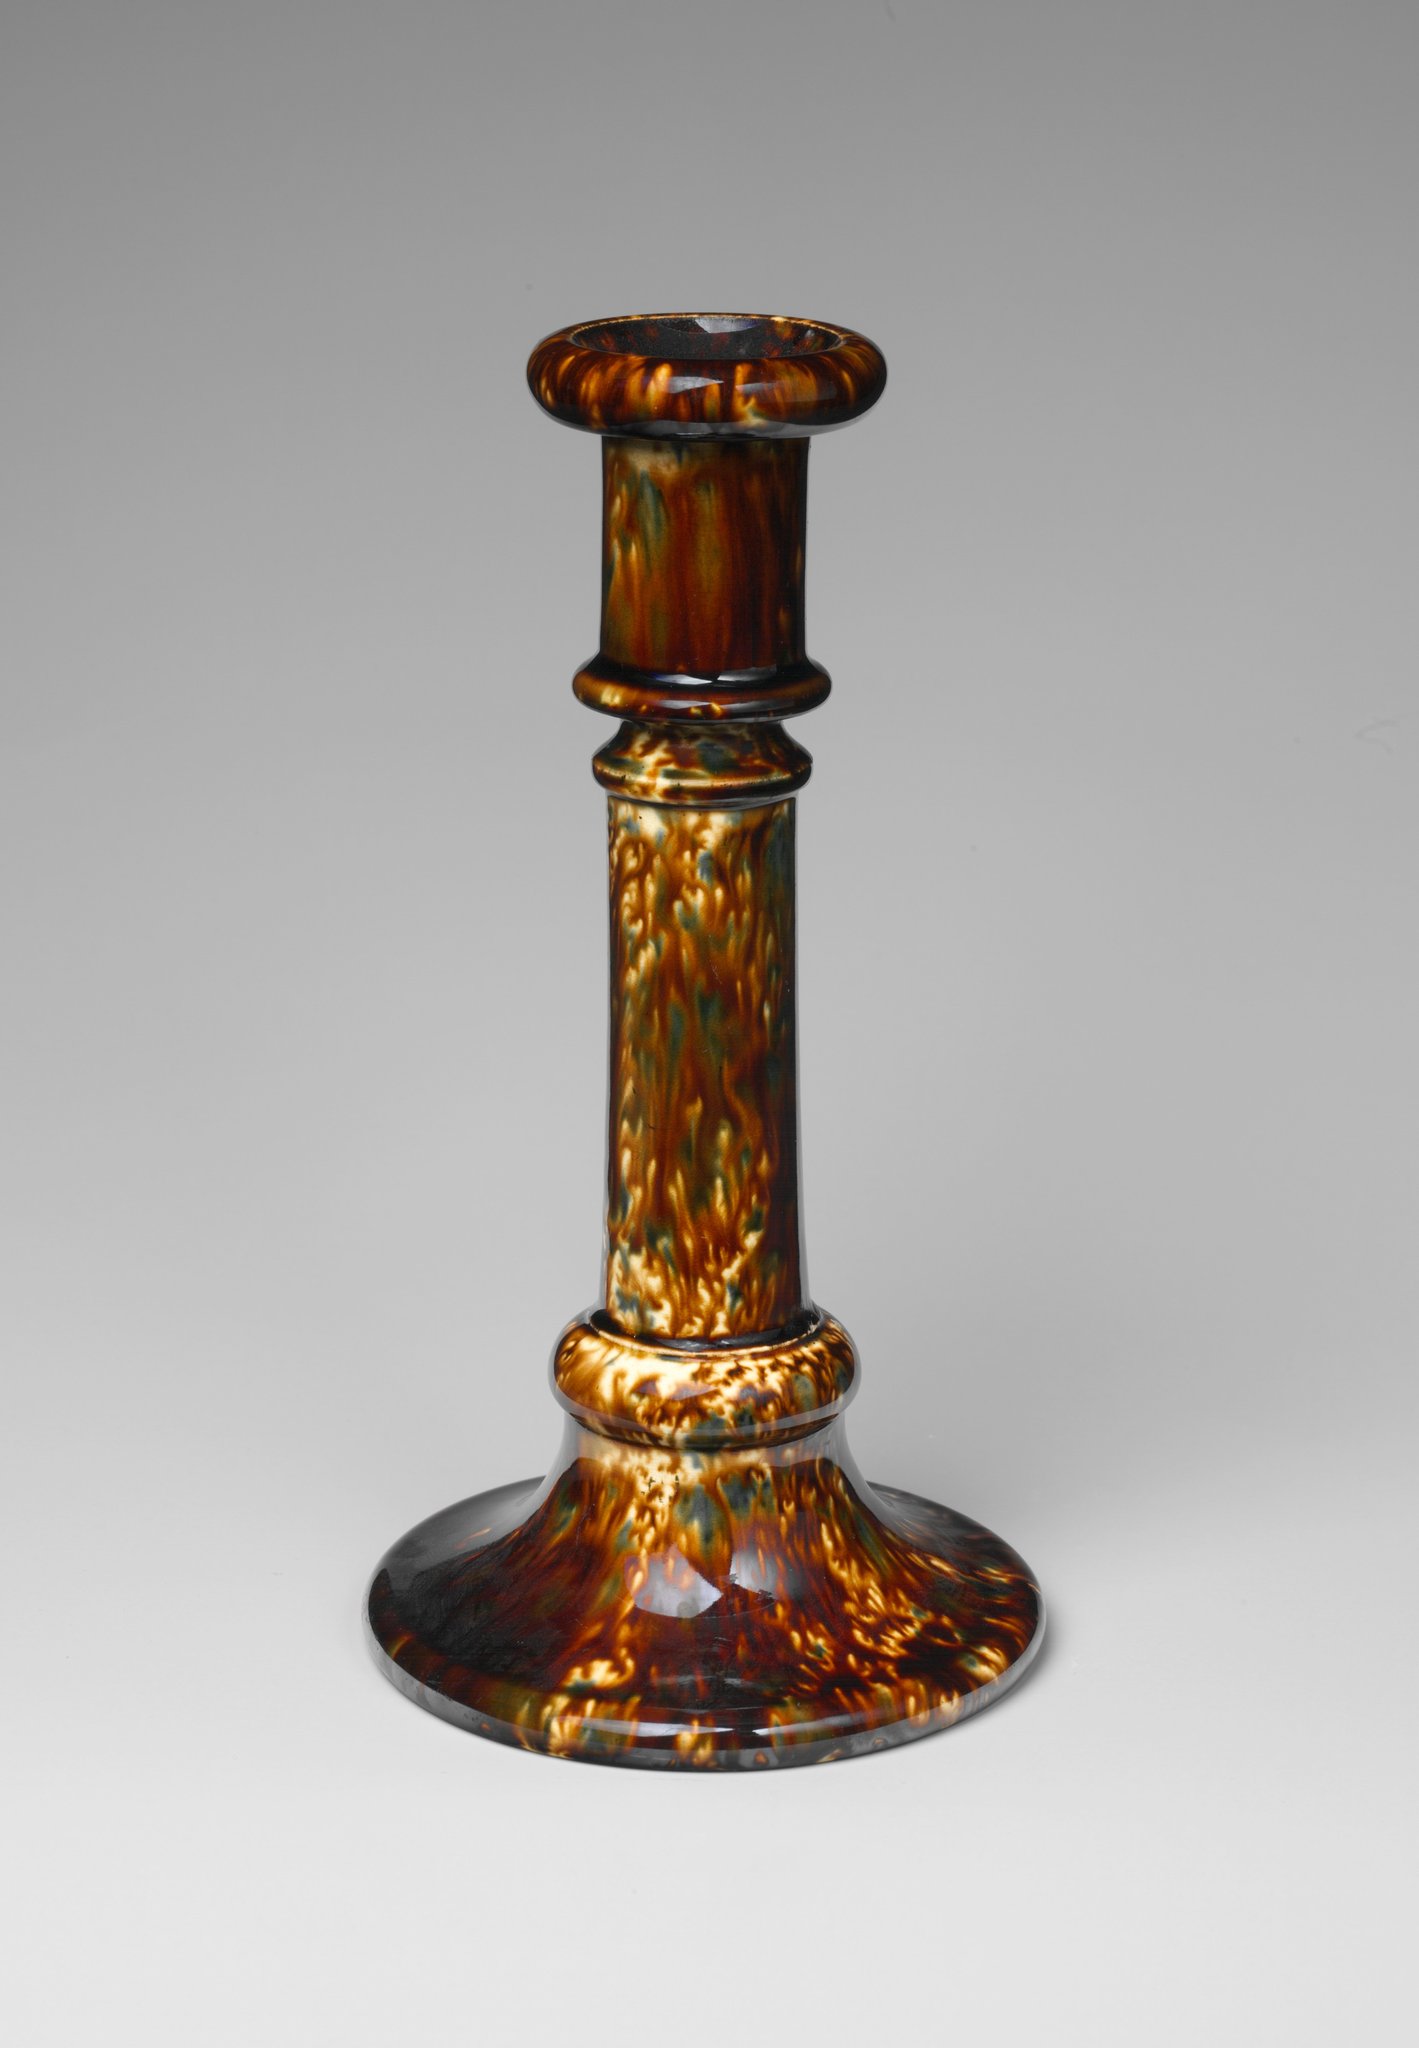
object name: candlestick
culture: american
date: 1820-1870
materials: earthenware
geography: united states